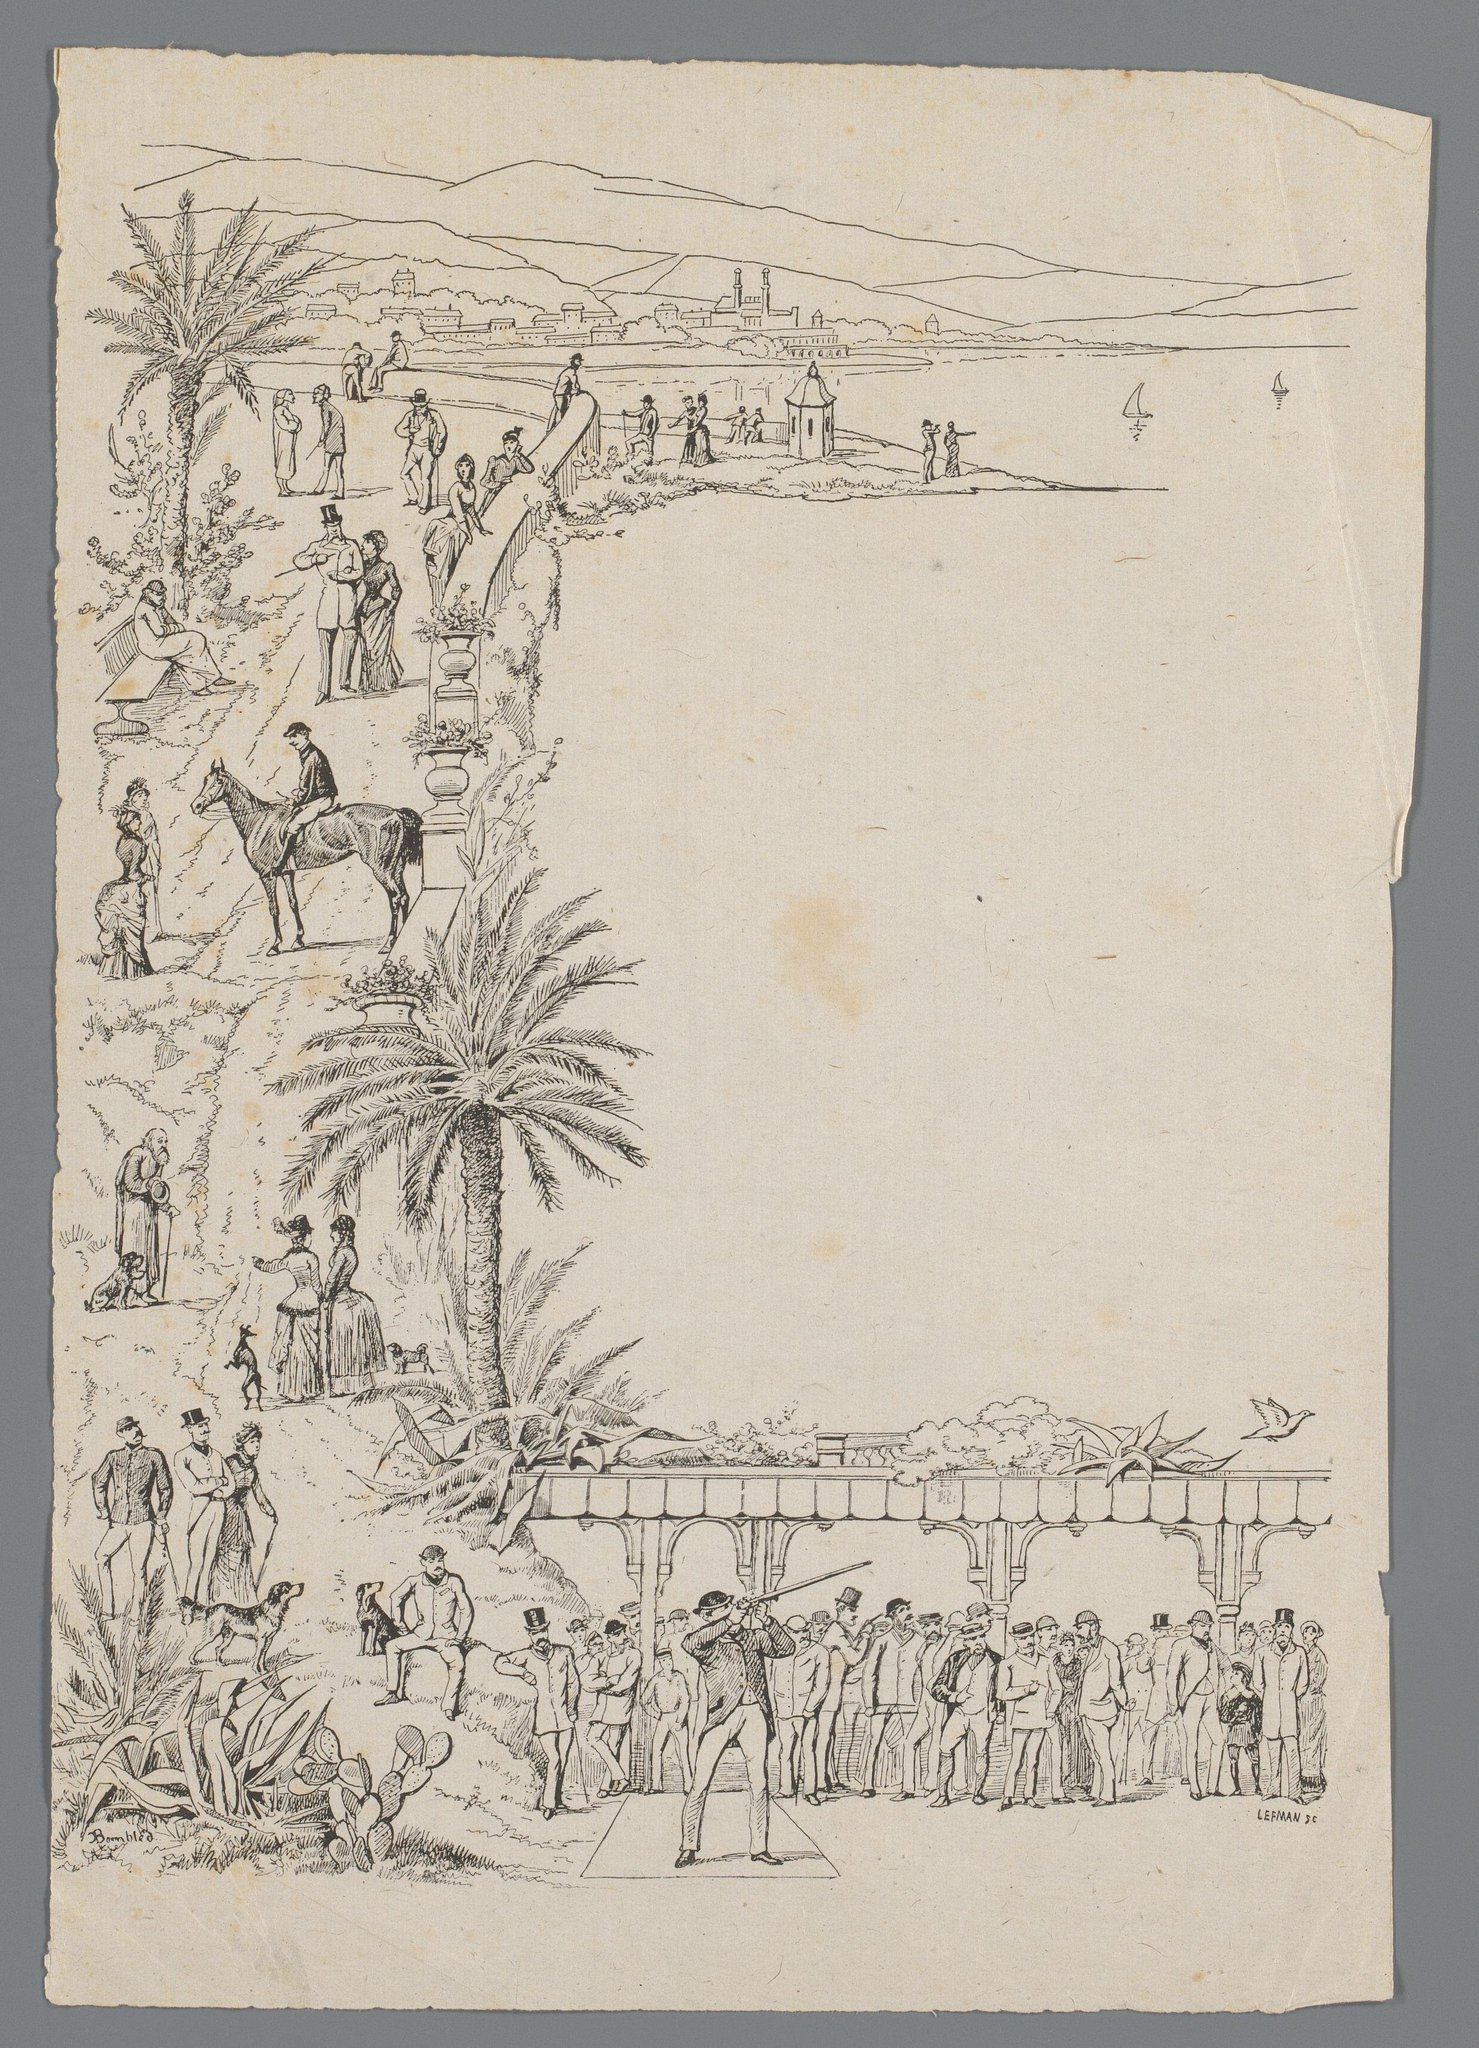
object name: stationery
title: Briefpapier met voorstellingen van vermaak aan een zuidelijke kust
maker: lefman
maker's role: print maker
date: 1800-1899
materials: paper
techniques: lithograph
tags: beach (as place of recreation), open-air recreation